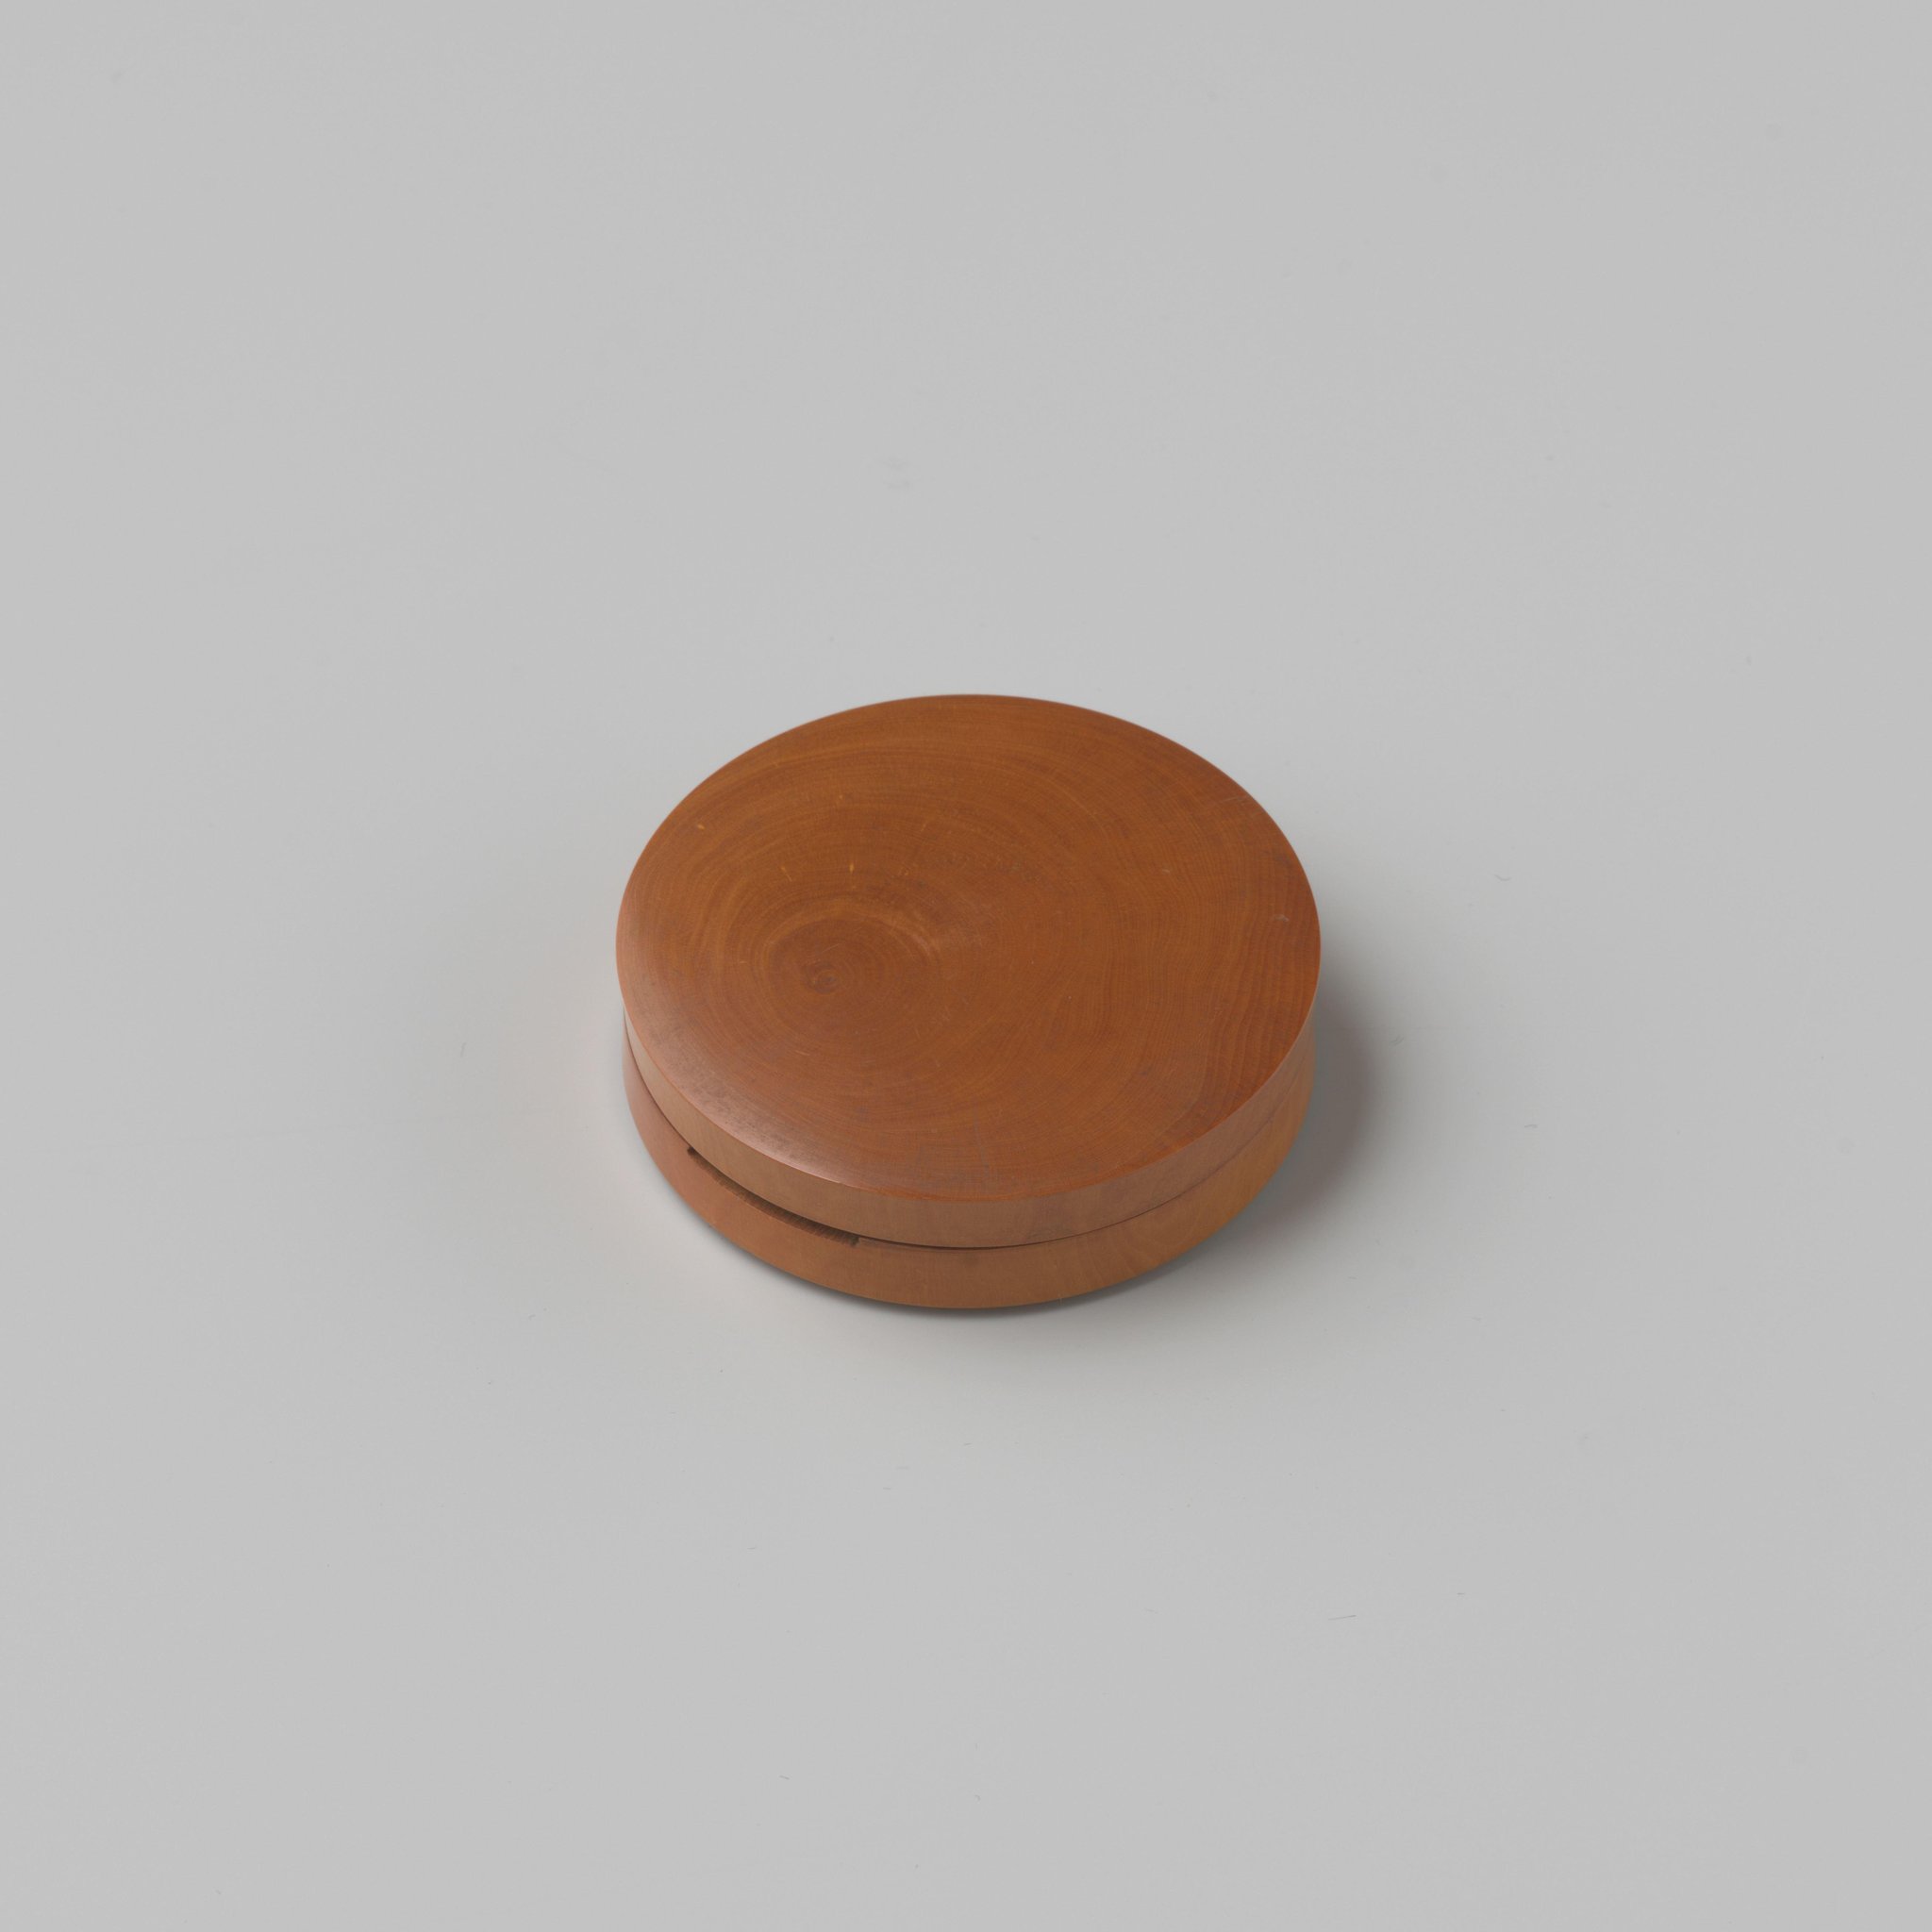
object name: history medal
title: penningdoos met aantekening "KOG 2488"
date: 1900-1940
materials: felt, wood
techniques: turning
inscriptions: inscription: ‘KOG 2488’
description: Gedraaide palmhouten doos en deksel, beide van binnen bekleed met rood vilt.